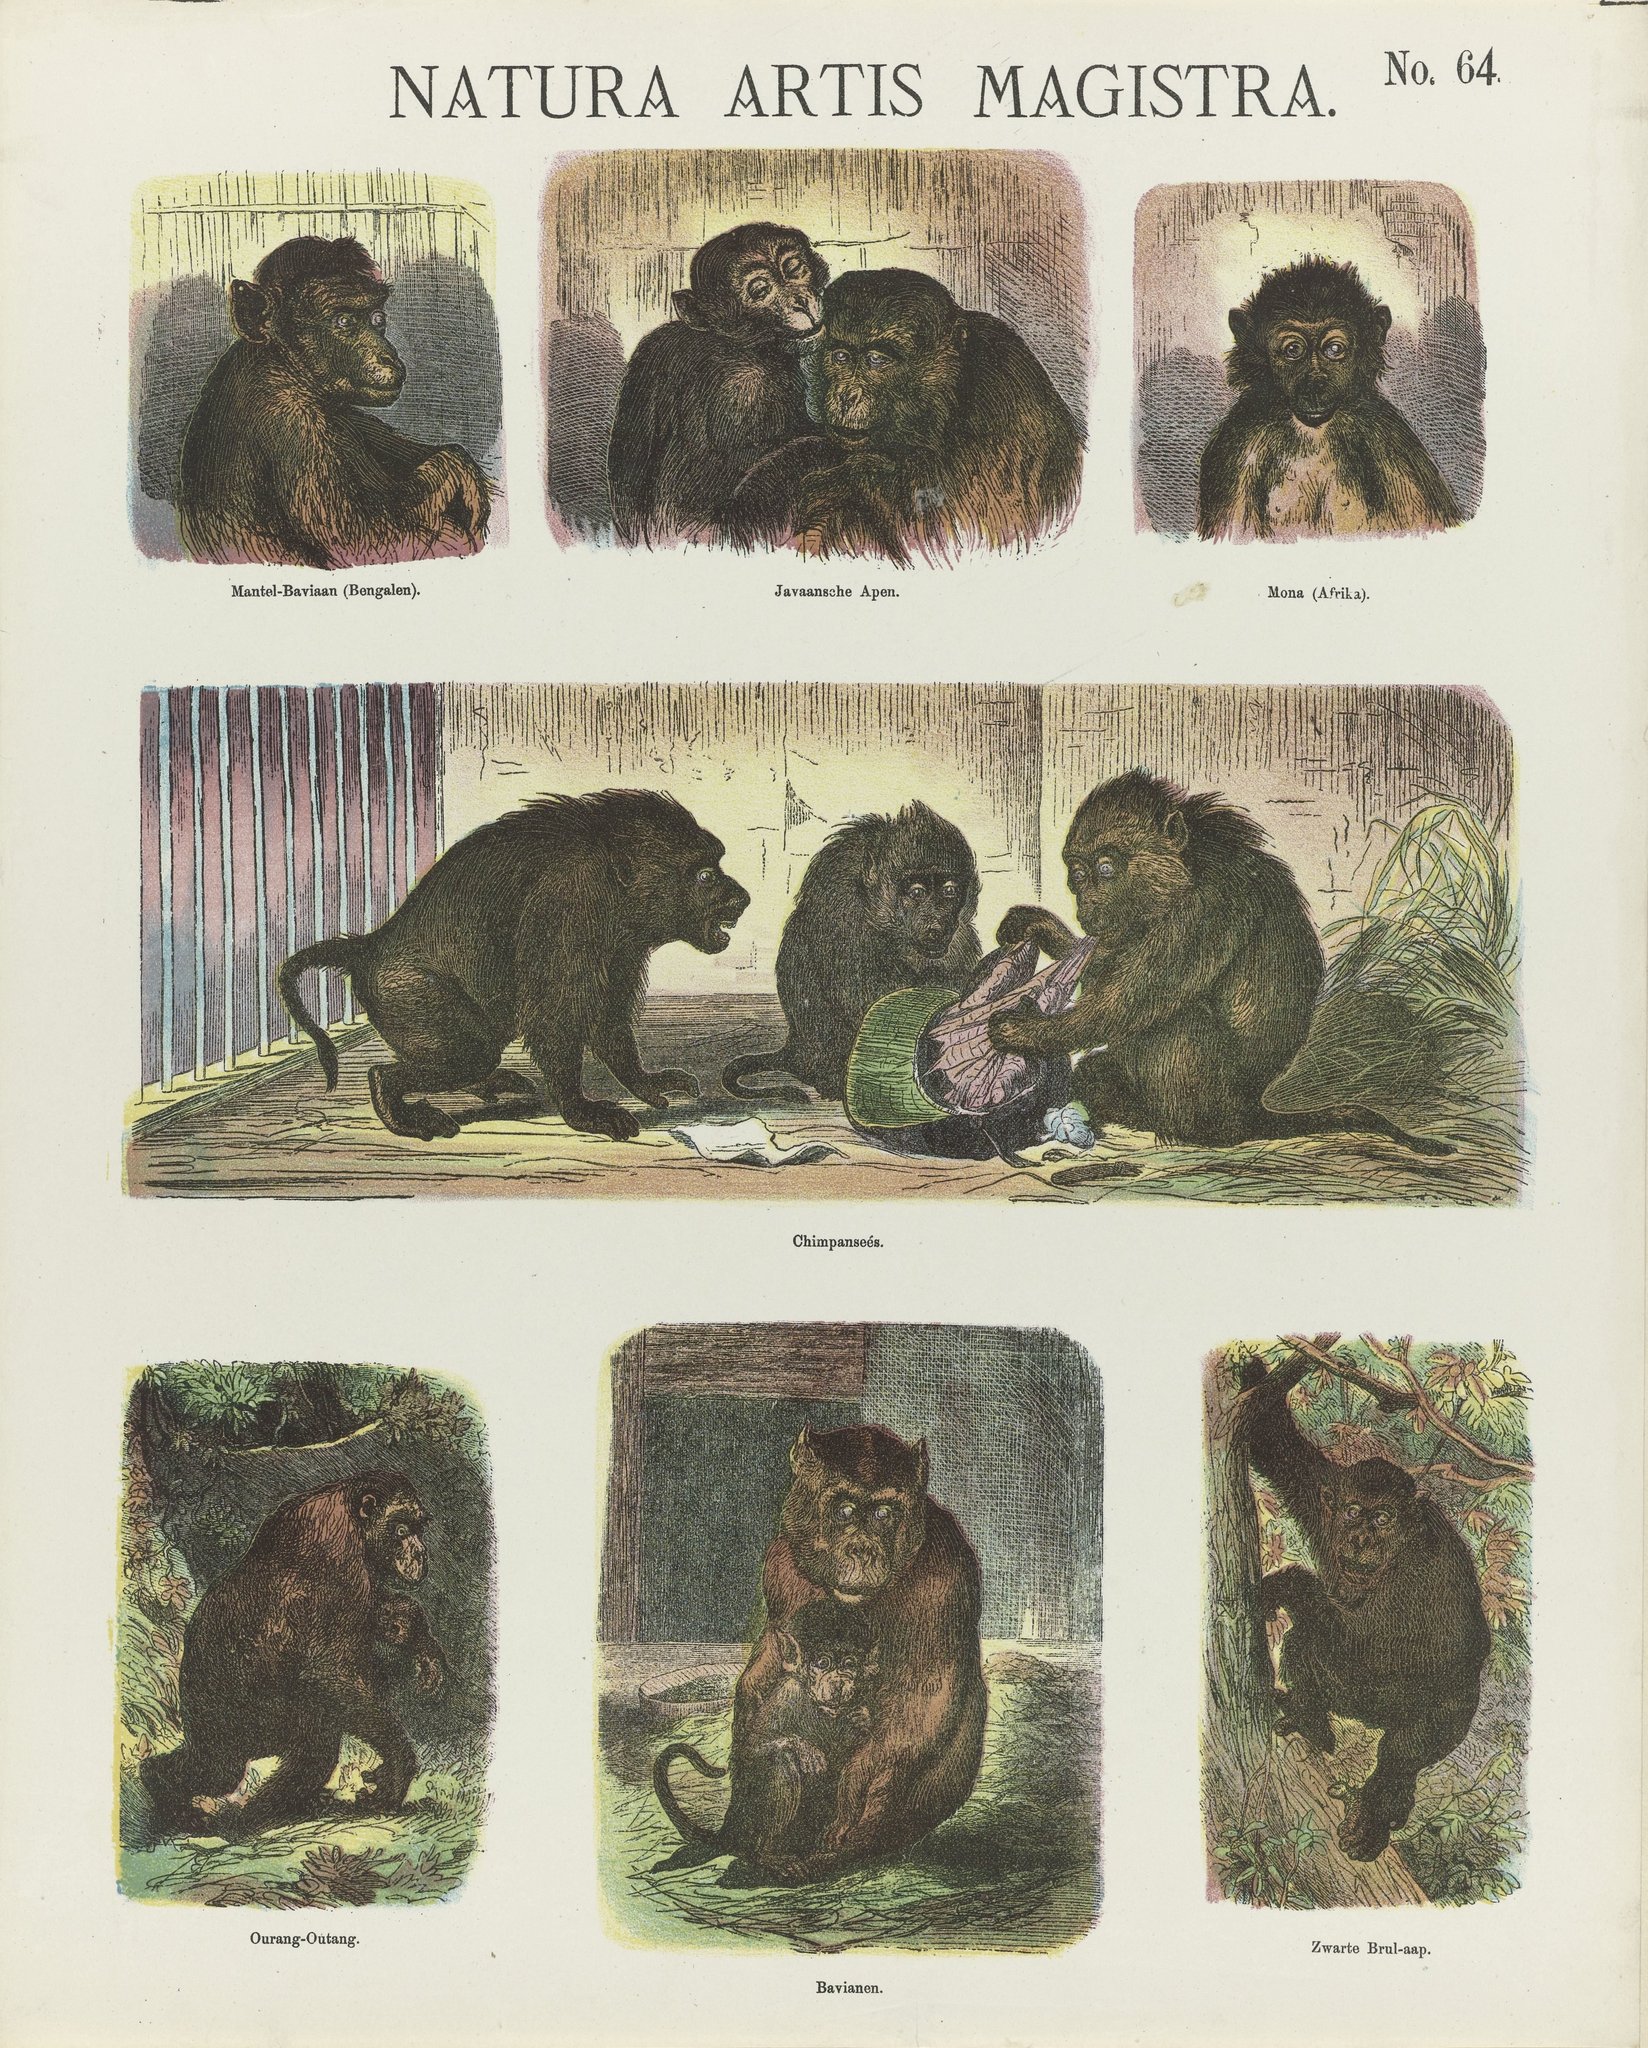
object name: popular print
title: Natura artis magistra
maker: Anonymous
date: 1878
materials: paper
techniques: lithograph, letterpress printing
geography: amsterdam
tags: monkeys, apes: baboon, monkeys, apes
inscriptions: collector's mark: Lugt 2760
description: Blad met 7 voorstellingen van apen, waaronder chimpansees, orang-oetans en bavianen. Onder elke afbeelding een onderschrift. Genummerd rechtsboven: No. 64.